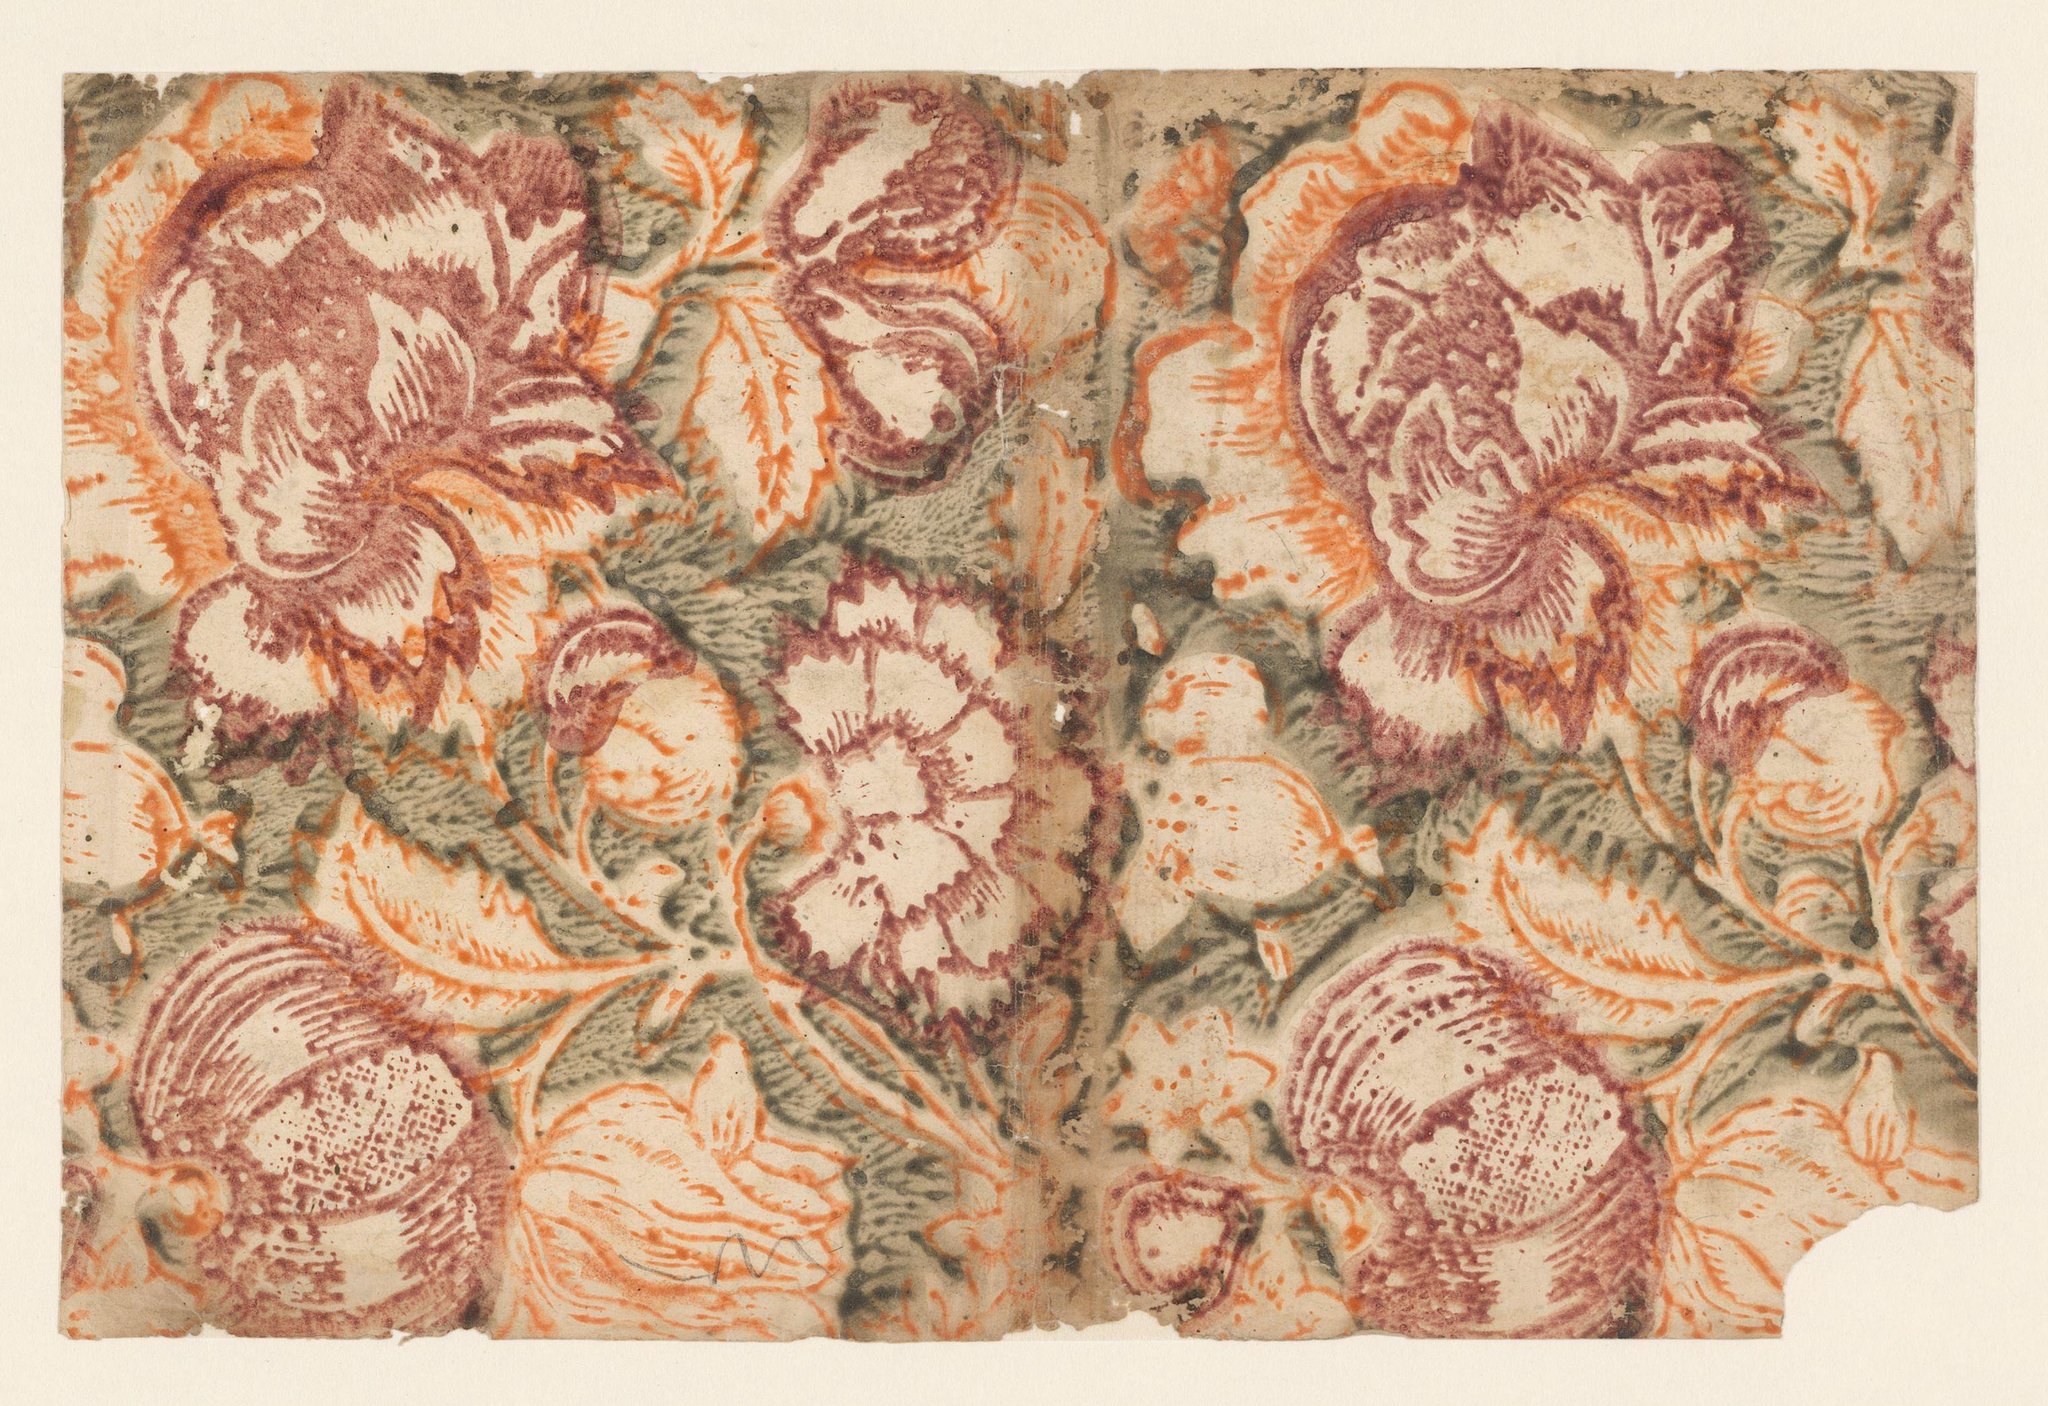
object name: printed paper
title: Blad met strooipatroon van bloemen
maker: Anonymous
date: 1700-1850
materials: paper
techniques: printing block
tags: ornament derived from plant forms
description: Blad met strooipatroon van grote bloemen. Gebruikt als omslag.